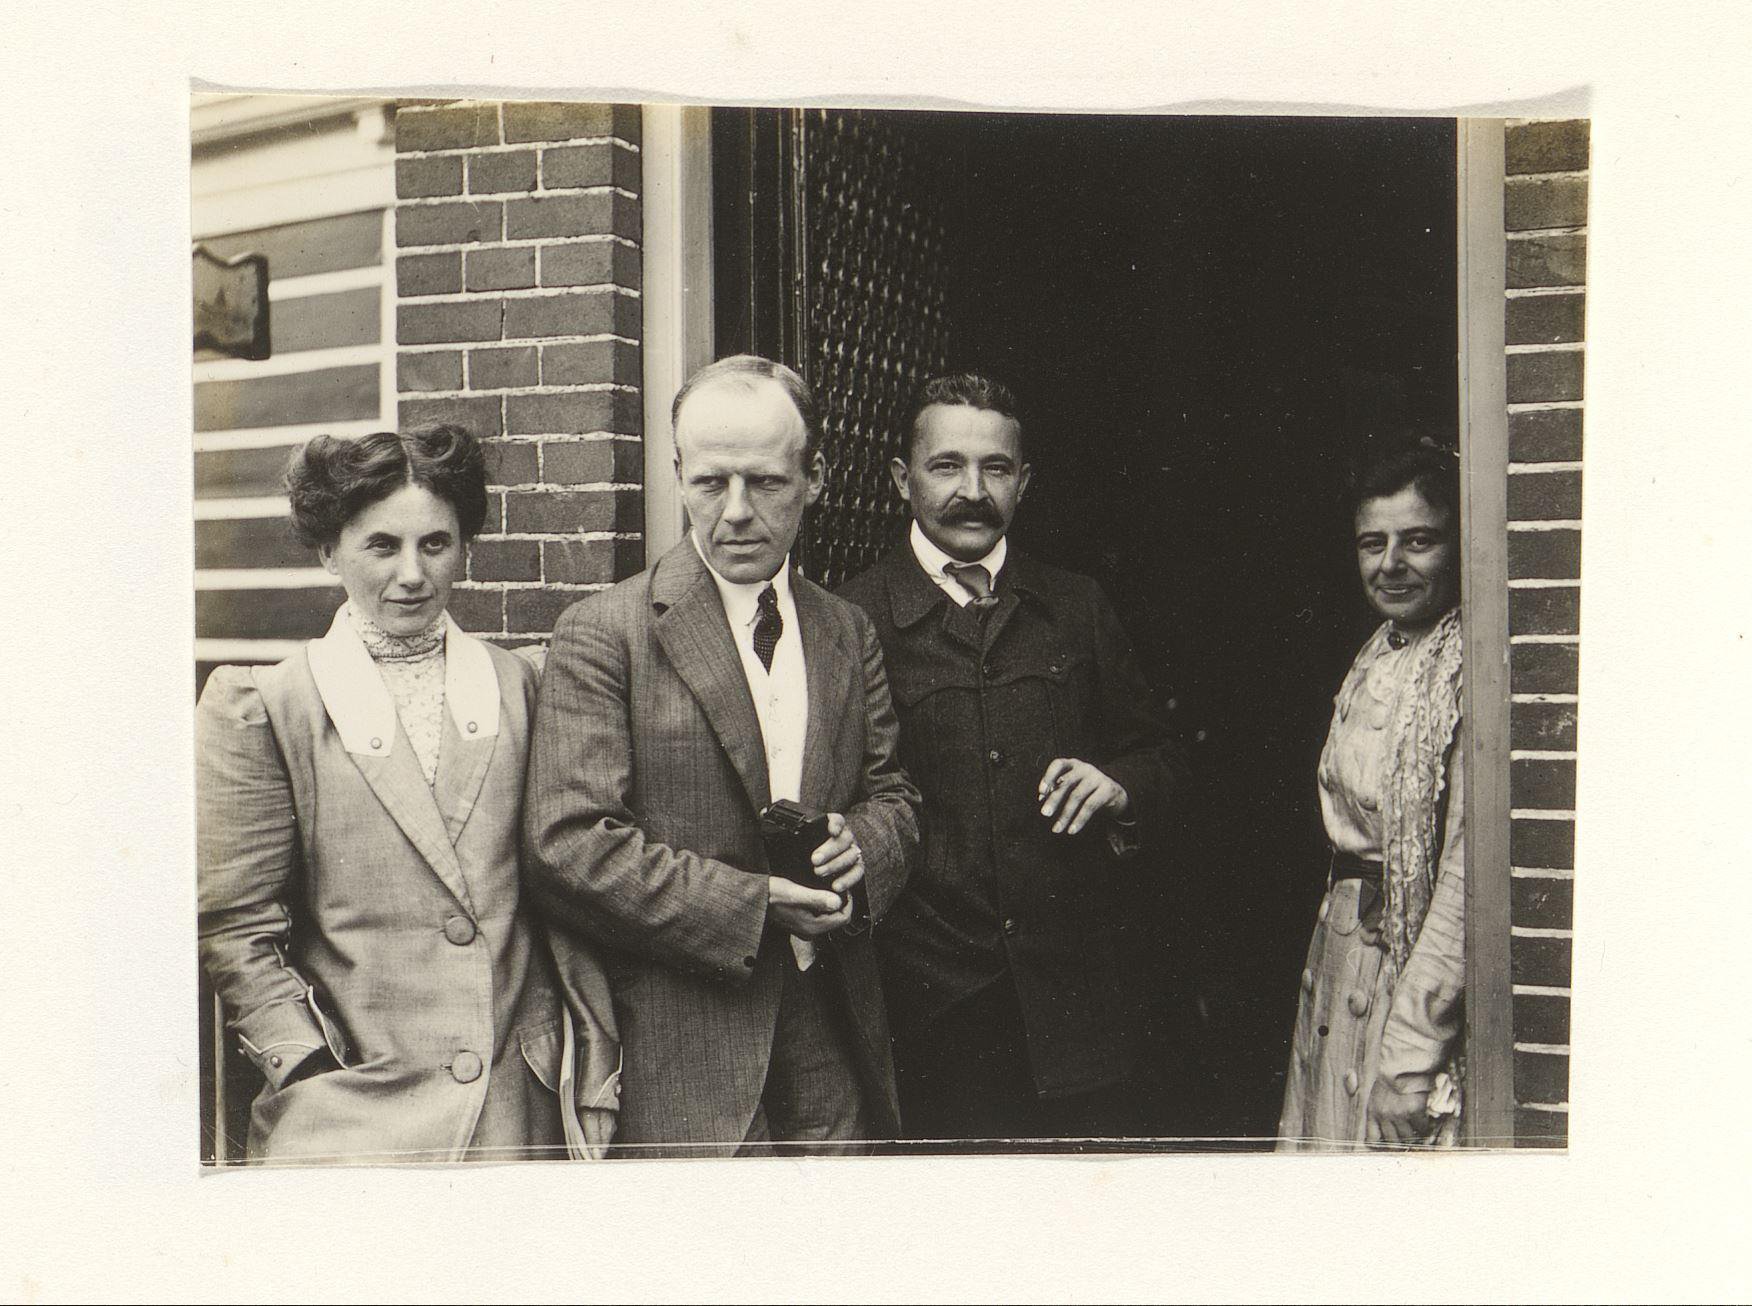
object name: album leaf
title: Mannen en vrouwen bij een deuropening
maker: george hidderley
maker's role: fotograaf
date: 1900-1910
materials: paper, photographic support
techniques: gelatin silver print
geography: volendam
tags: adult woman, open door, adult man, historical persons